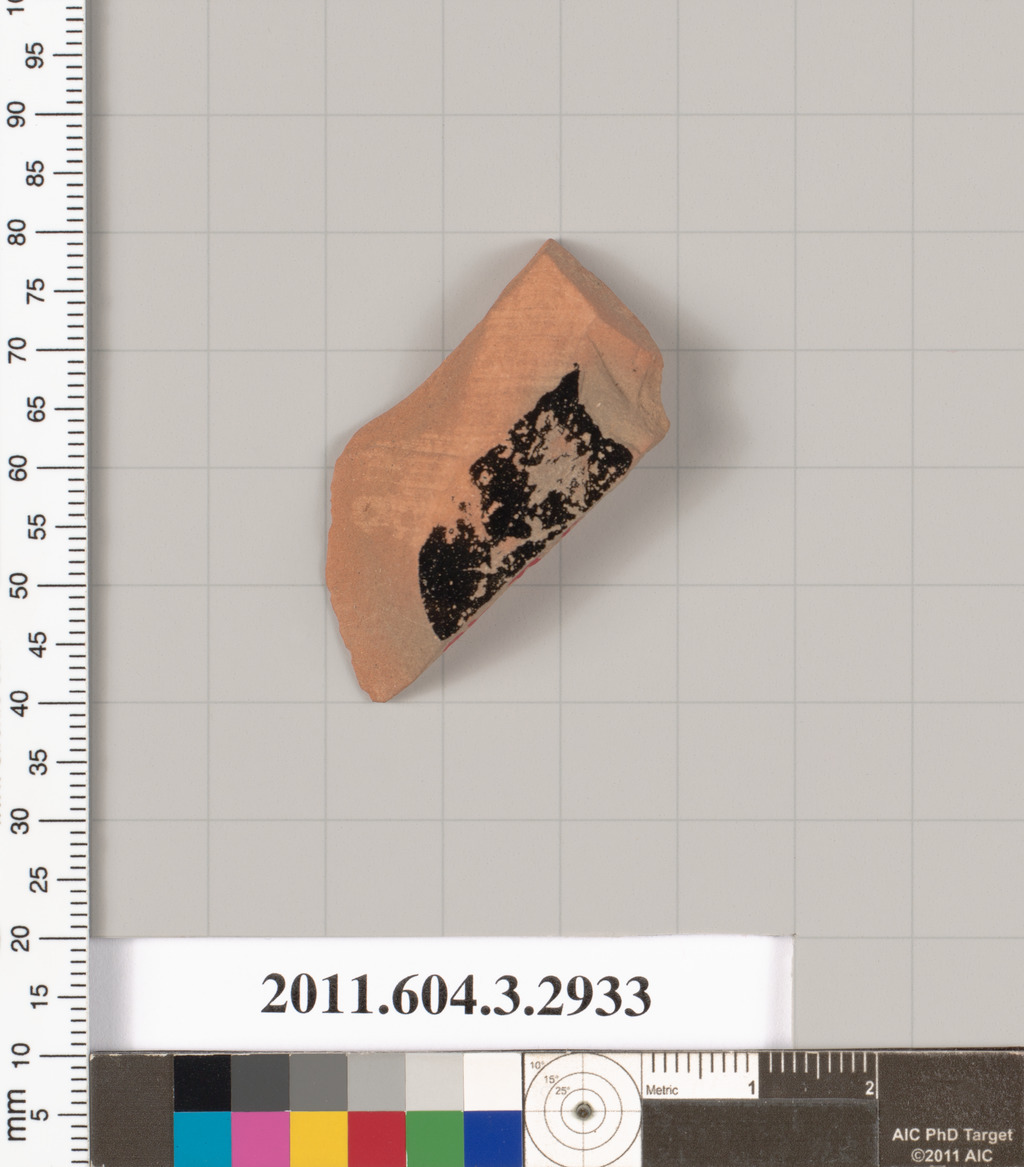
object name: undetermined closed shape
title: Terracotta fragment of a closed shape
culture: greek, attic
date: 600-401 BCE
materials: terracotta